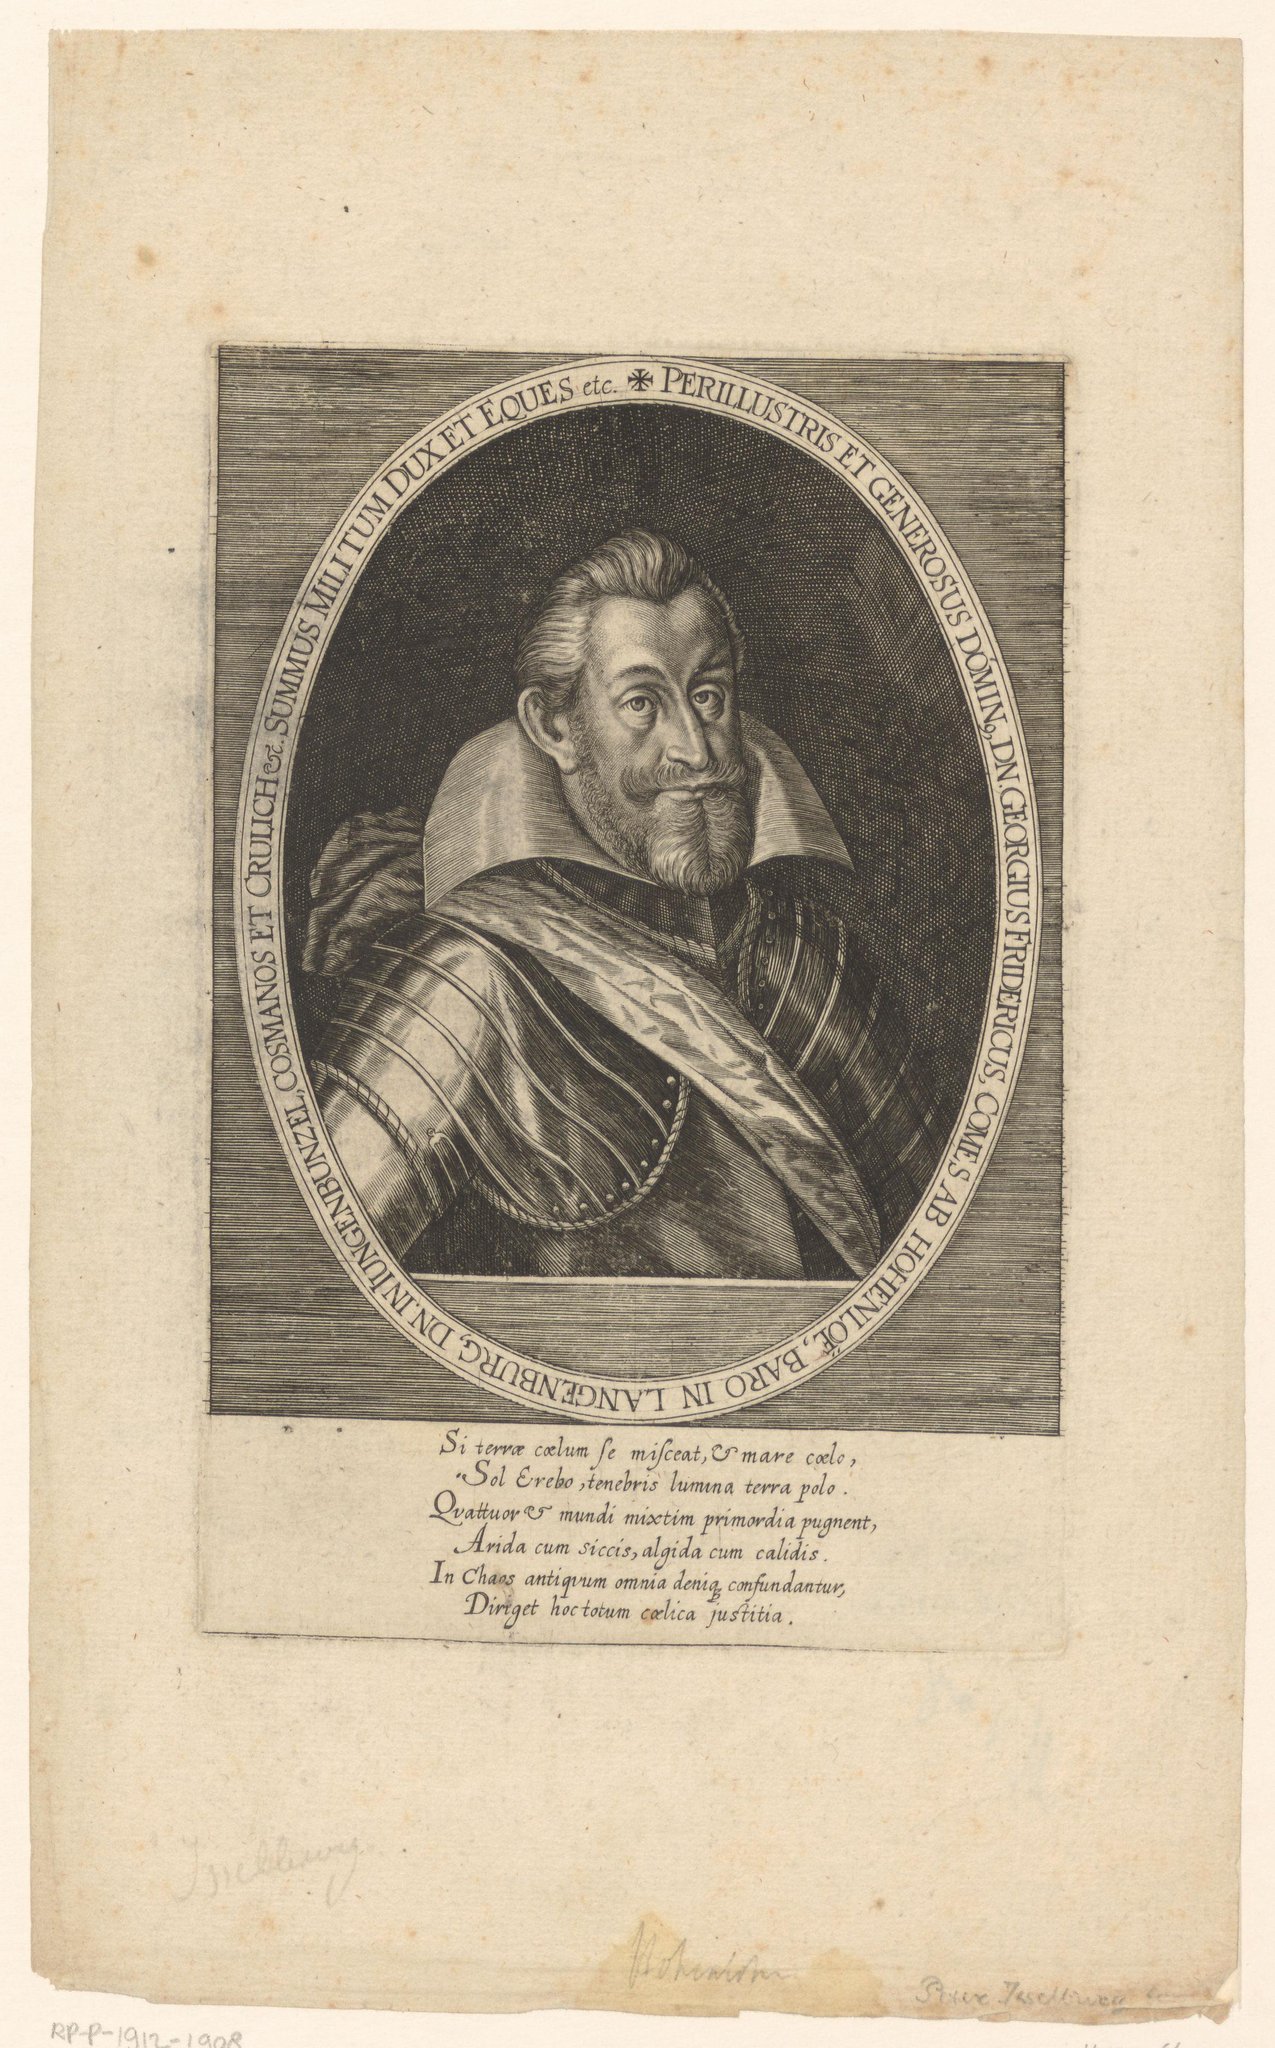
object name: print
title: Portret van George Hohenlohe-Langenburg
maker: peter isselburg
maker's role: print maker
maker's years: 1568-1630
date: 1578-1630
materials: paper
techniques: engraving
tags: commander-in-chief, general, marshal, historical persons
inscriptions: collector's mark: Lugt 2228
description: Deze prent is mogelijk gebaseerd op een prent van Wolfgang Kilian uit 1620, of vice versa, aanwezig in de HAB: A 25495.